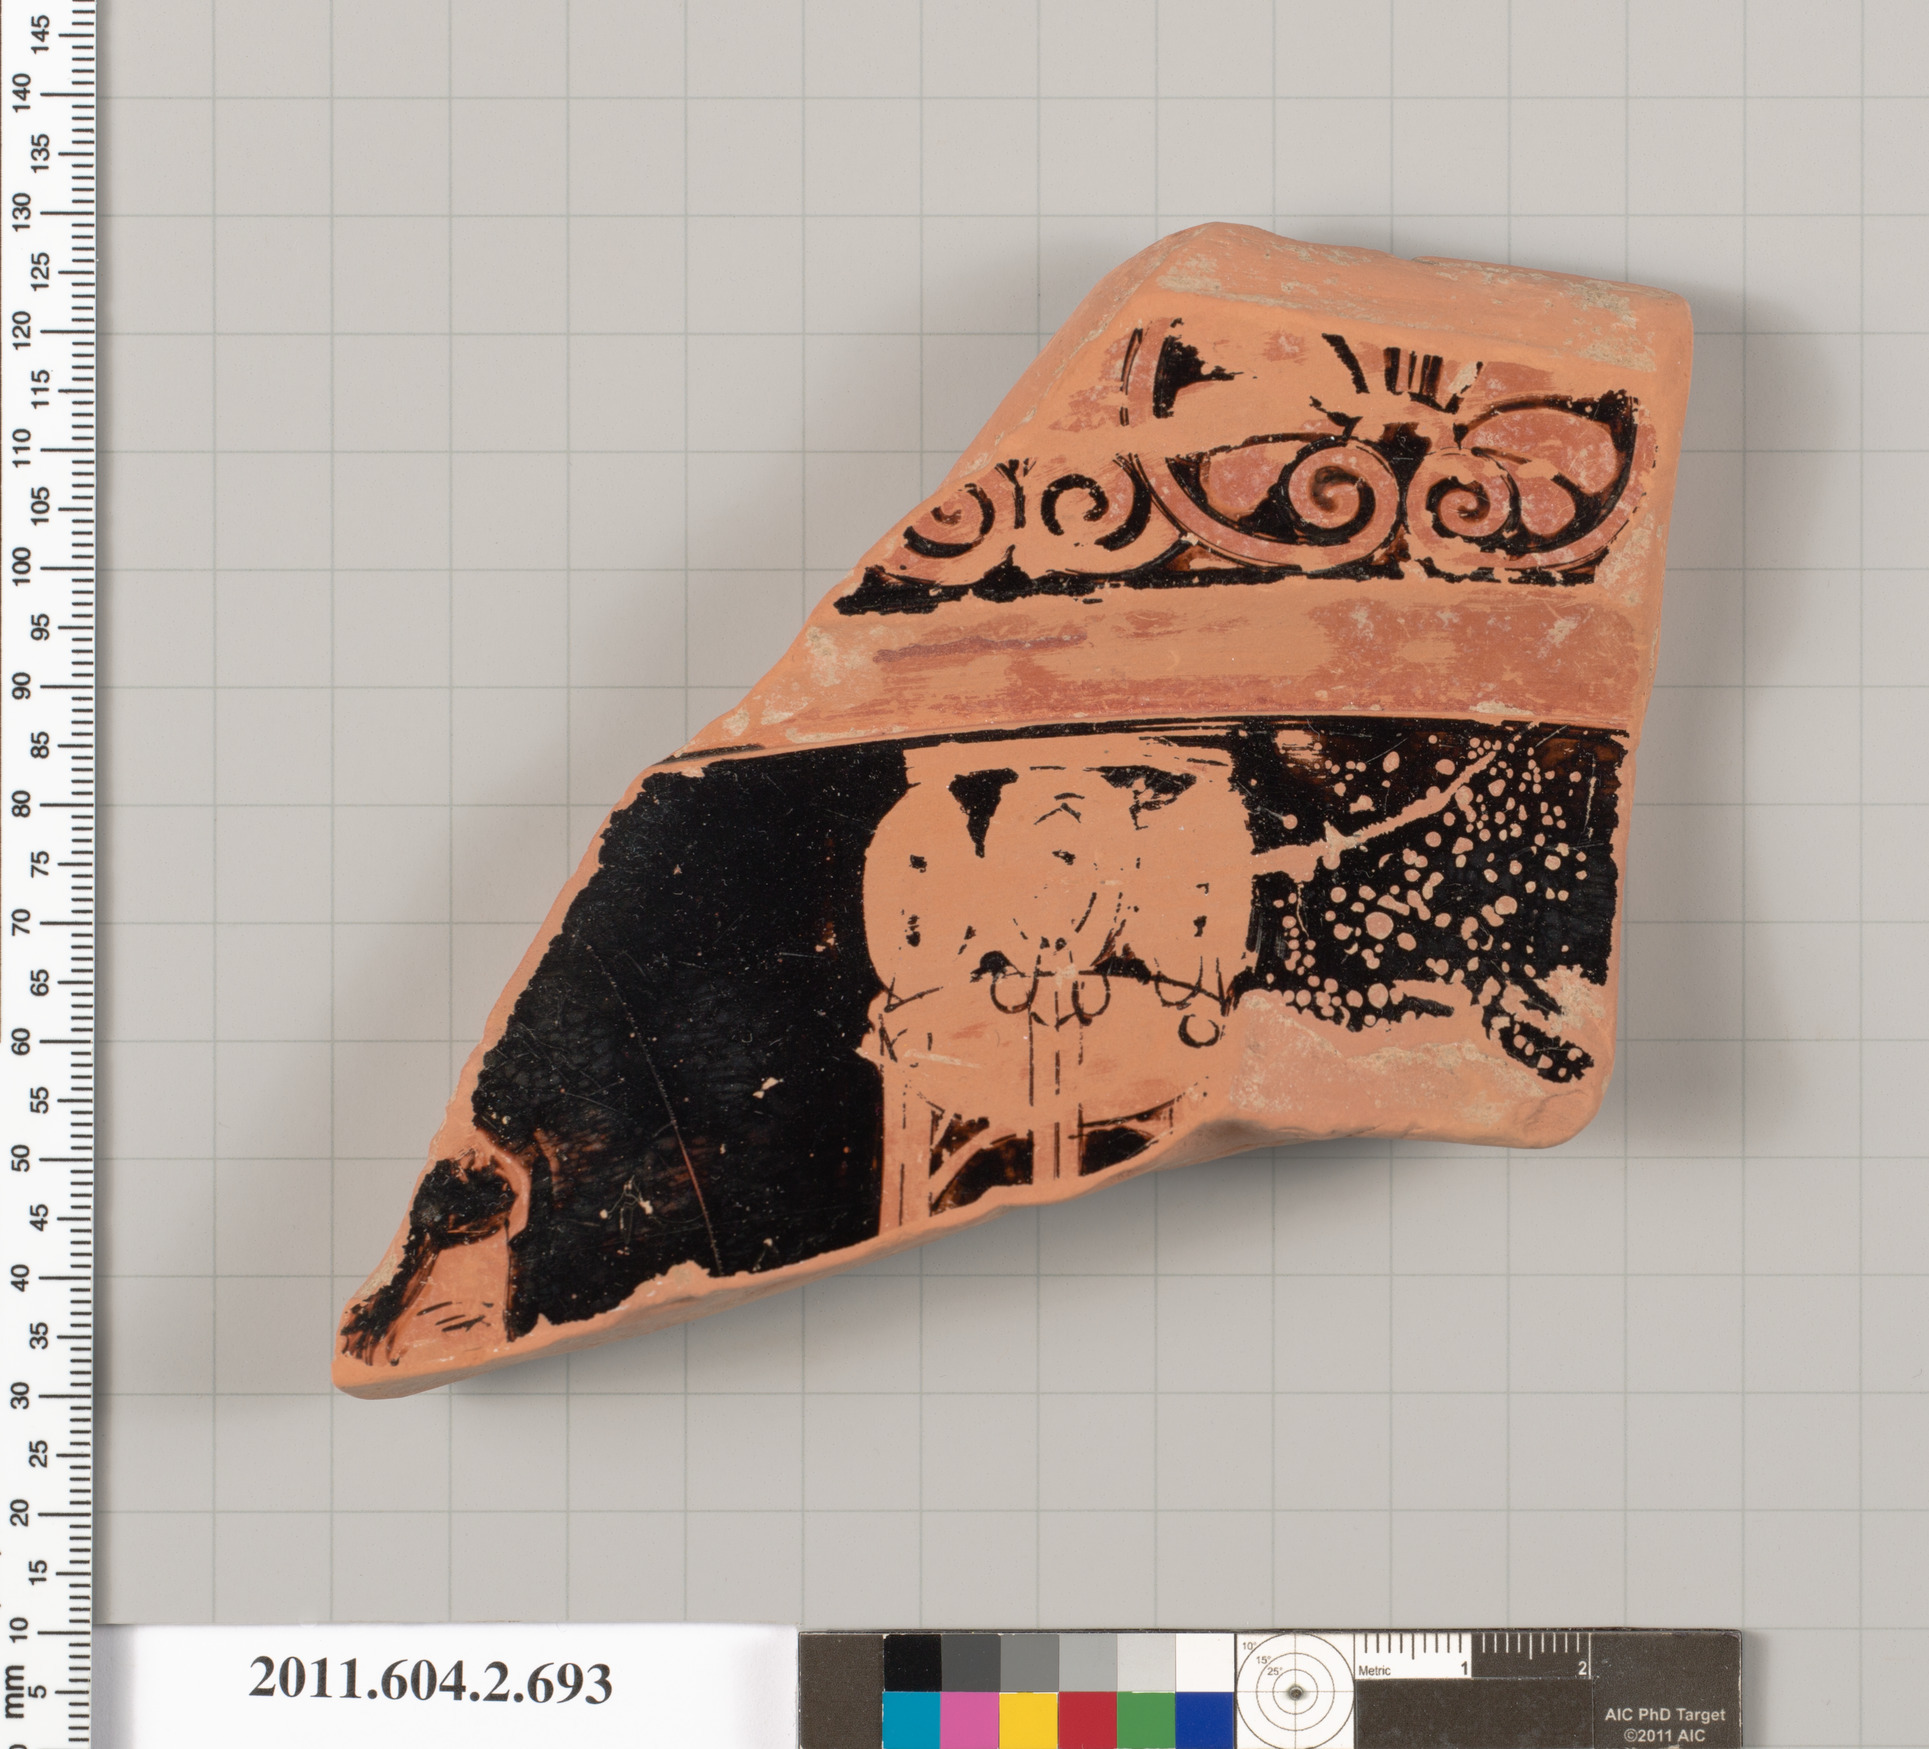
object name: calyx krater fragment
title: Terracotta fragment of a calyx-krater (bowl for mixing wine and water)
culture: greek, attic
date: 467-435 BCE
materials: terracotta